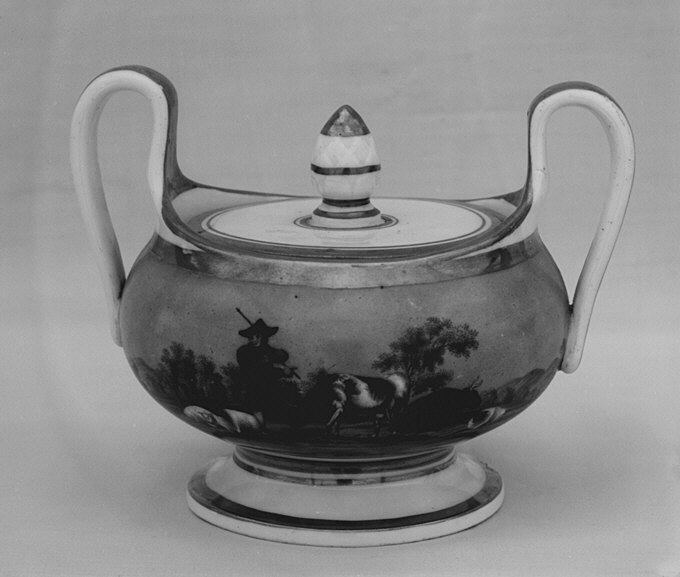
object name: sugar bowl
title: Sugar bowl (part of a set)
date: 1820-1830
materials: hard paste porcelain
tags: human figures,animals